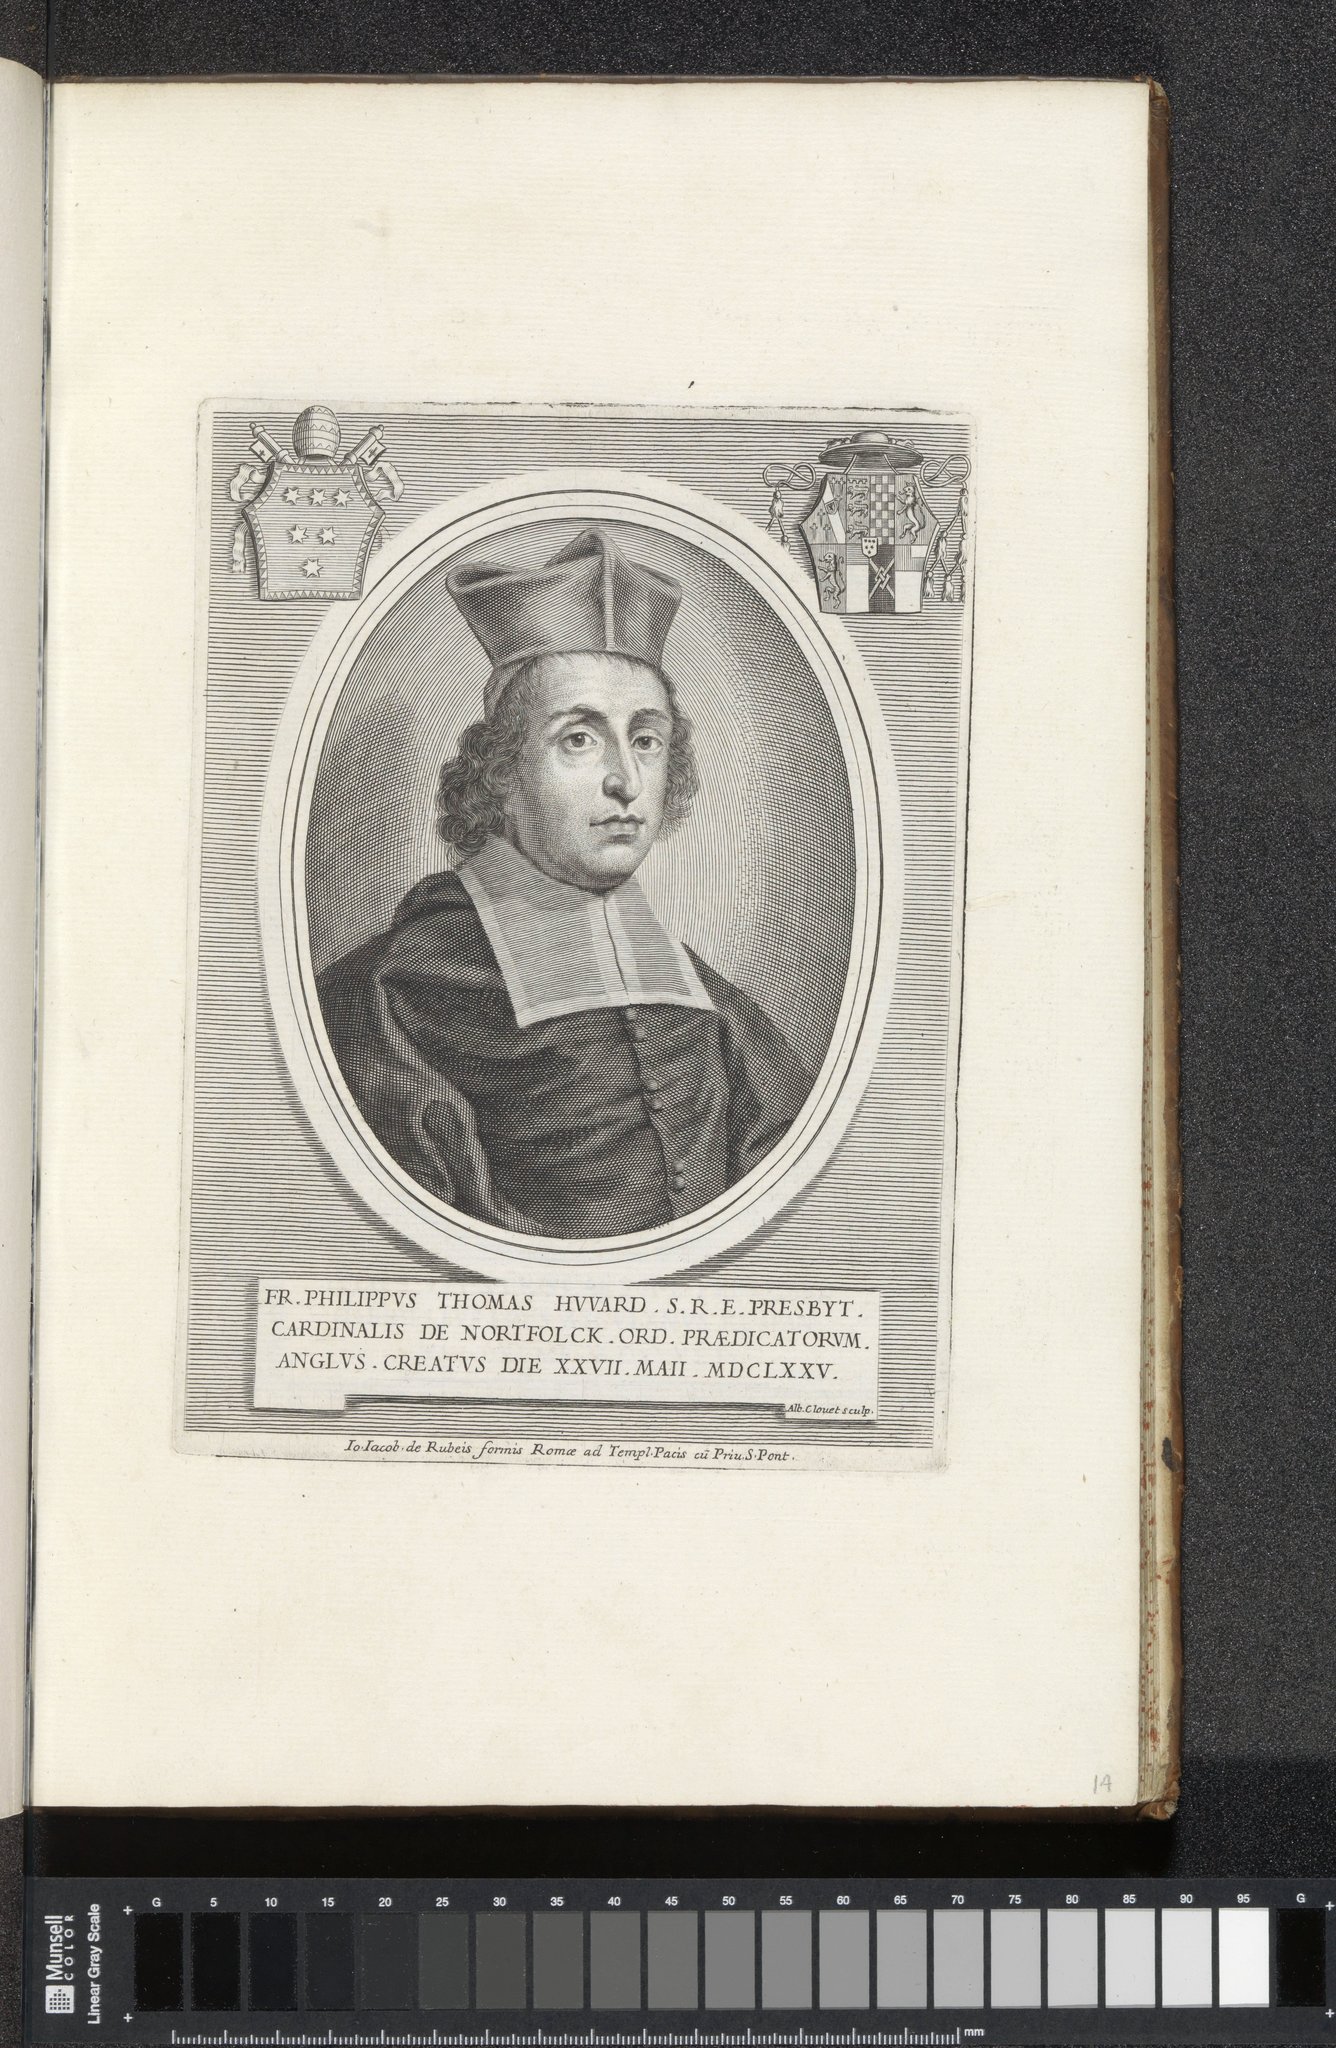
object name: print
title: Portret van kardinaal Philip Thomas Howard of Norfolk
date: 1675-1679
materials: paper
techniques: engraving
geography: rome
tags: london, rome, cardinal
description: Portret van kardinaal Philip Thomas Howard of Norfolk. Linksboven het wapen van paus Clemens X en rechtsboven het wapen van de kardinaal. Onderaan een onderschrift in het Latijn. De prent maakt deel uit van een album.